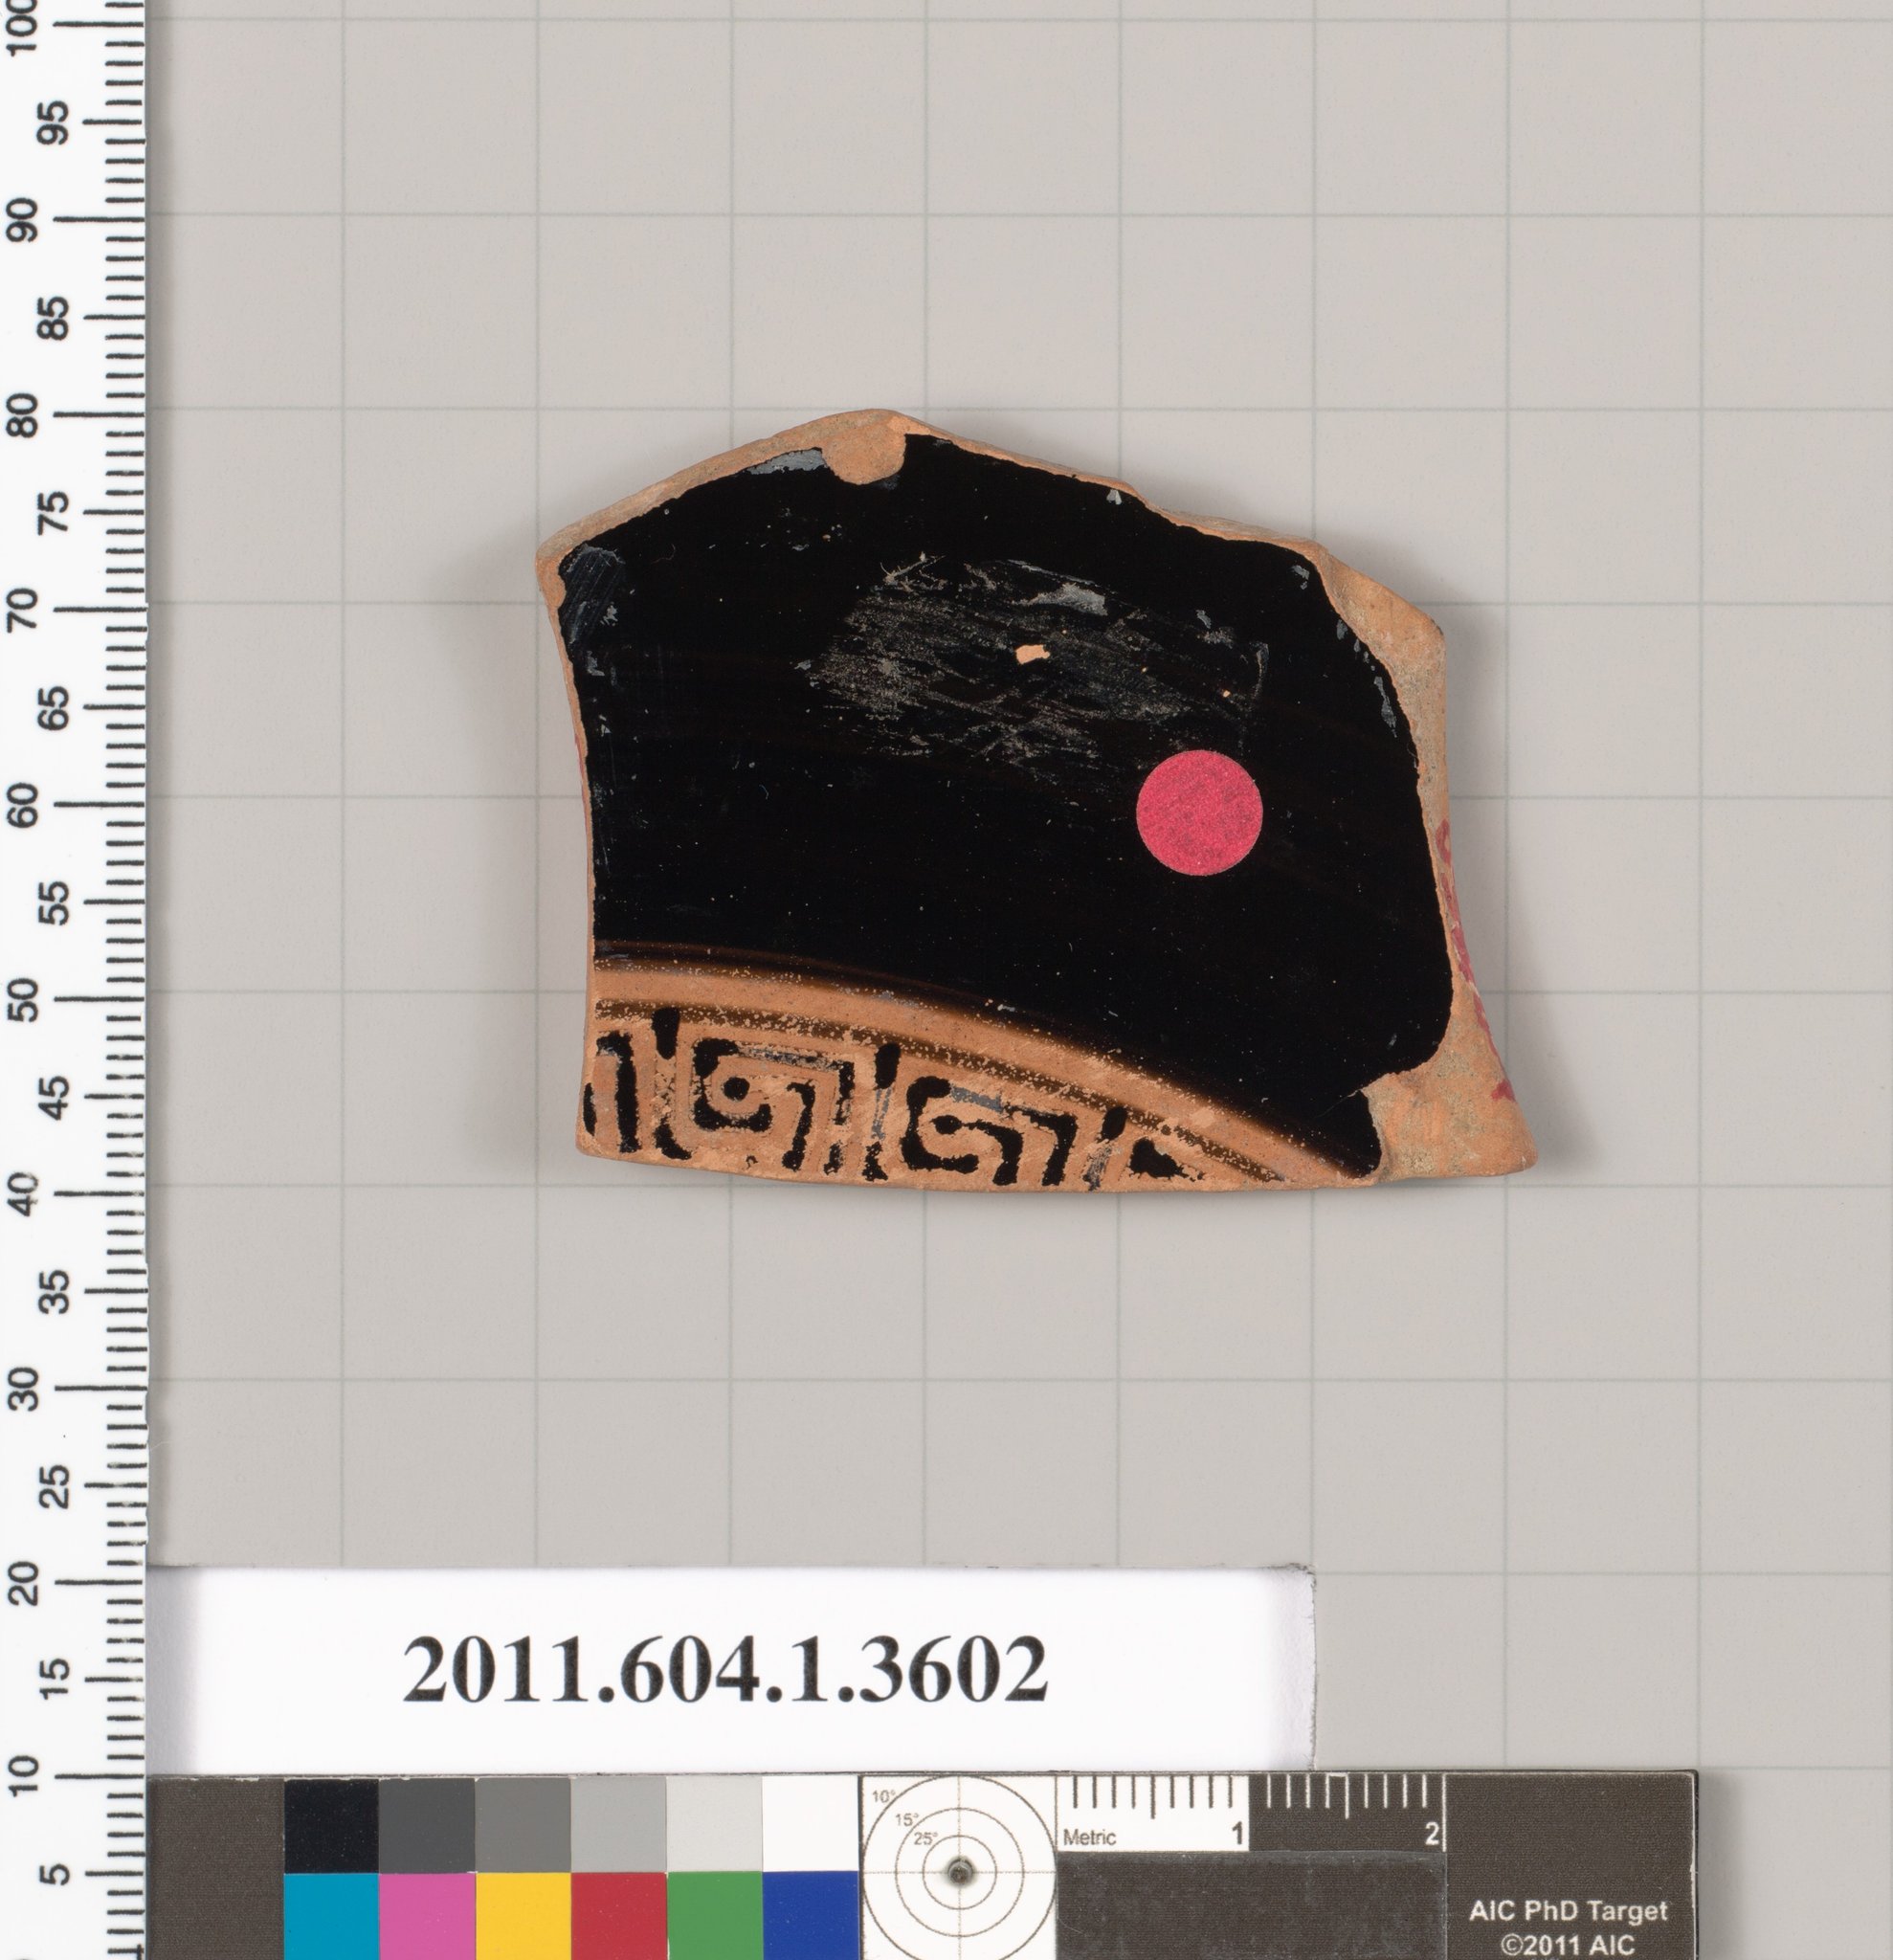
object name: kylix fragment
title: Terracotta fragment of a kylix (drinking cup)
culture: greek, attic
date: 490-480 BCE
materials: terracotta